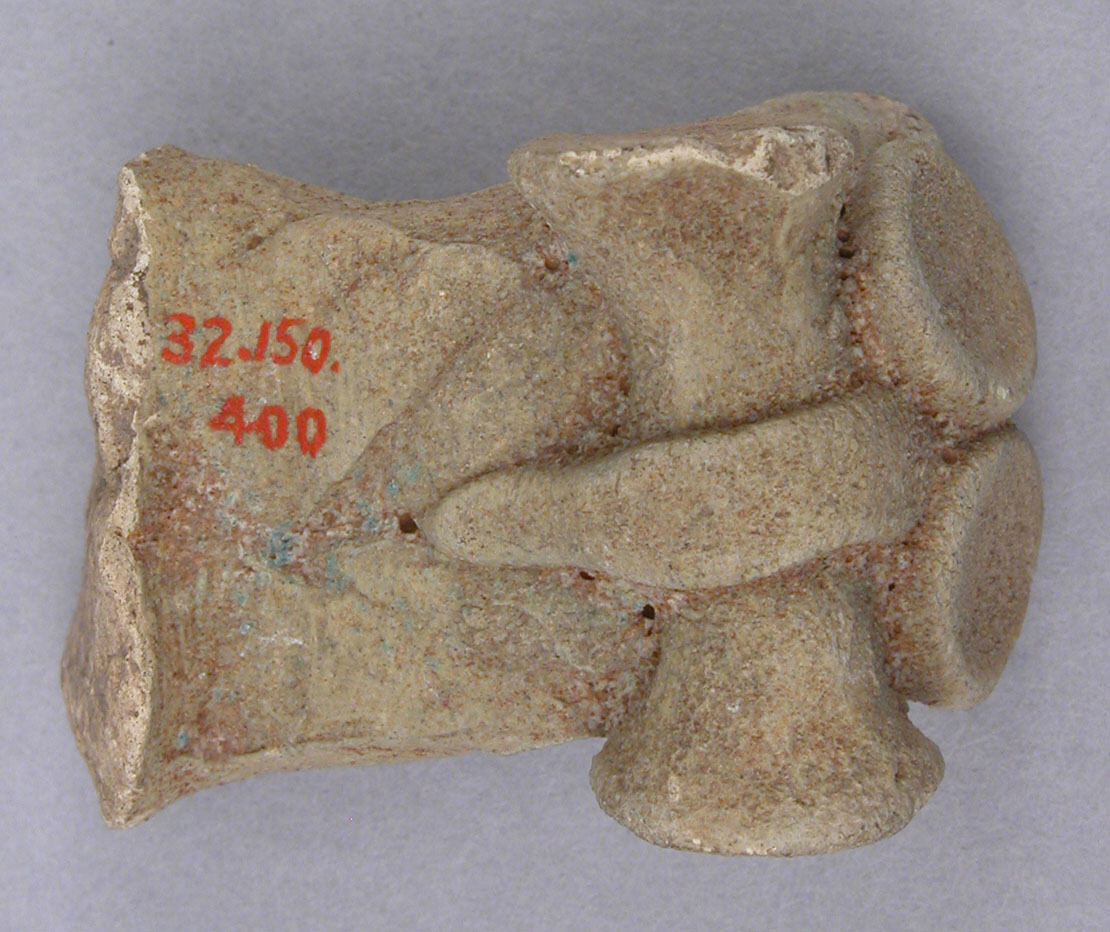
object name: fragment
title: Ceramic Fragment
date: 701-900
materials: earthenware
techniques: molding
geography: iraq